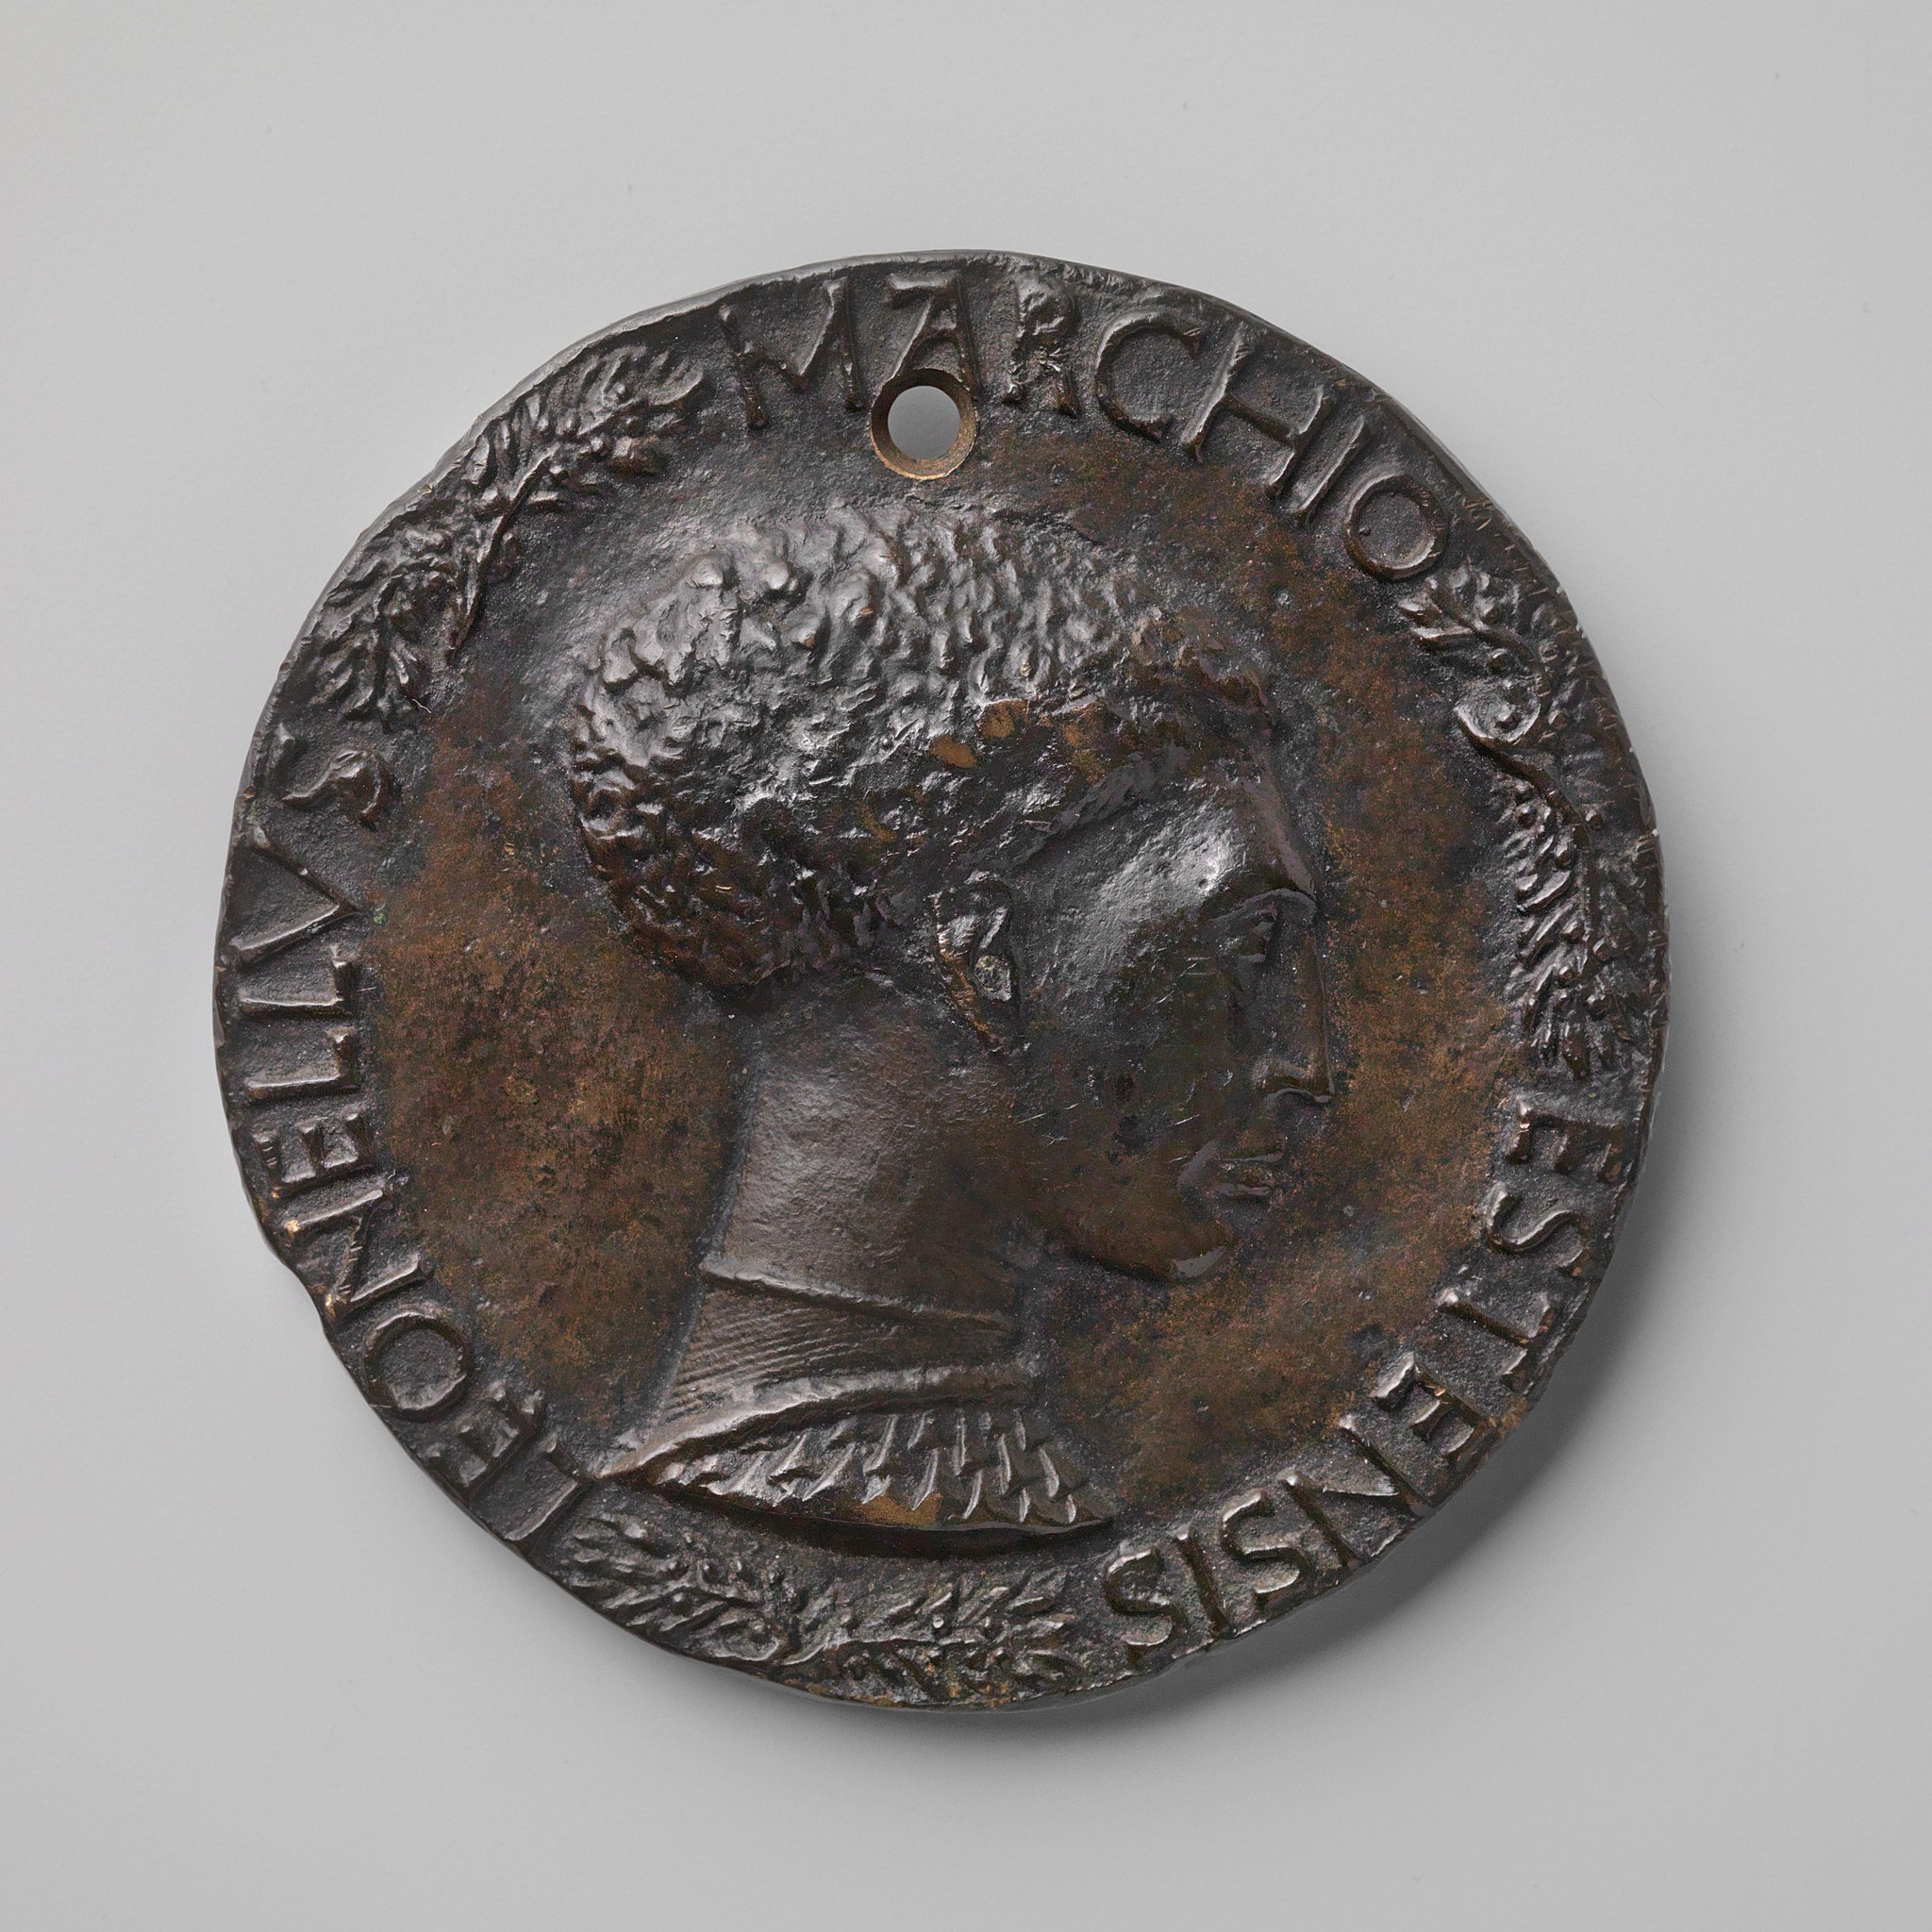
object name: medal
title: Leonello d'Este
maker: antonio pisanello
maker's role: draughtsman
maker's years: 1395-1455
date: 1441-1444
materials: bronze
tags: lionello di este (hertog van ferrara)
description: Penning, brons. Voorzijde: een buste van een man naar rechts met het randschrift: "Leonellus Marchio Estensis". Deze woorden zijn door een olijftak van elkaar gescheiden. Keerzijde: drie kindergezichten aan een hoofd met slechts twee ogen. Aan weerszijden hiervan olijftakken met aangehangen pantserdelen. Randschrift: "Opus Pisani Pictoris". De medaille boven aan de rand doorboord. Mogelijk latere gieting.